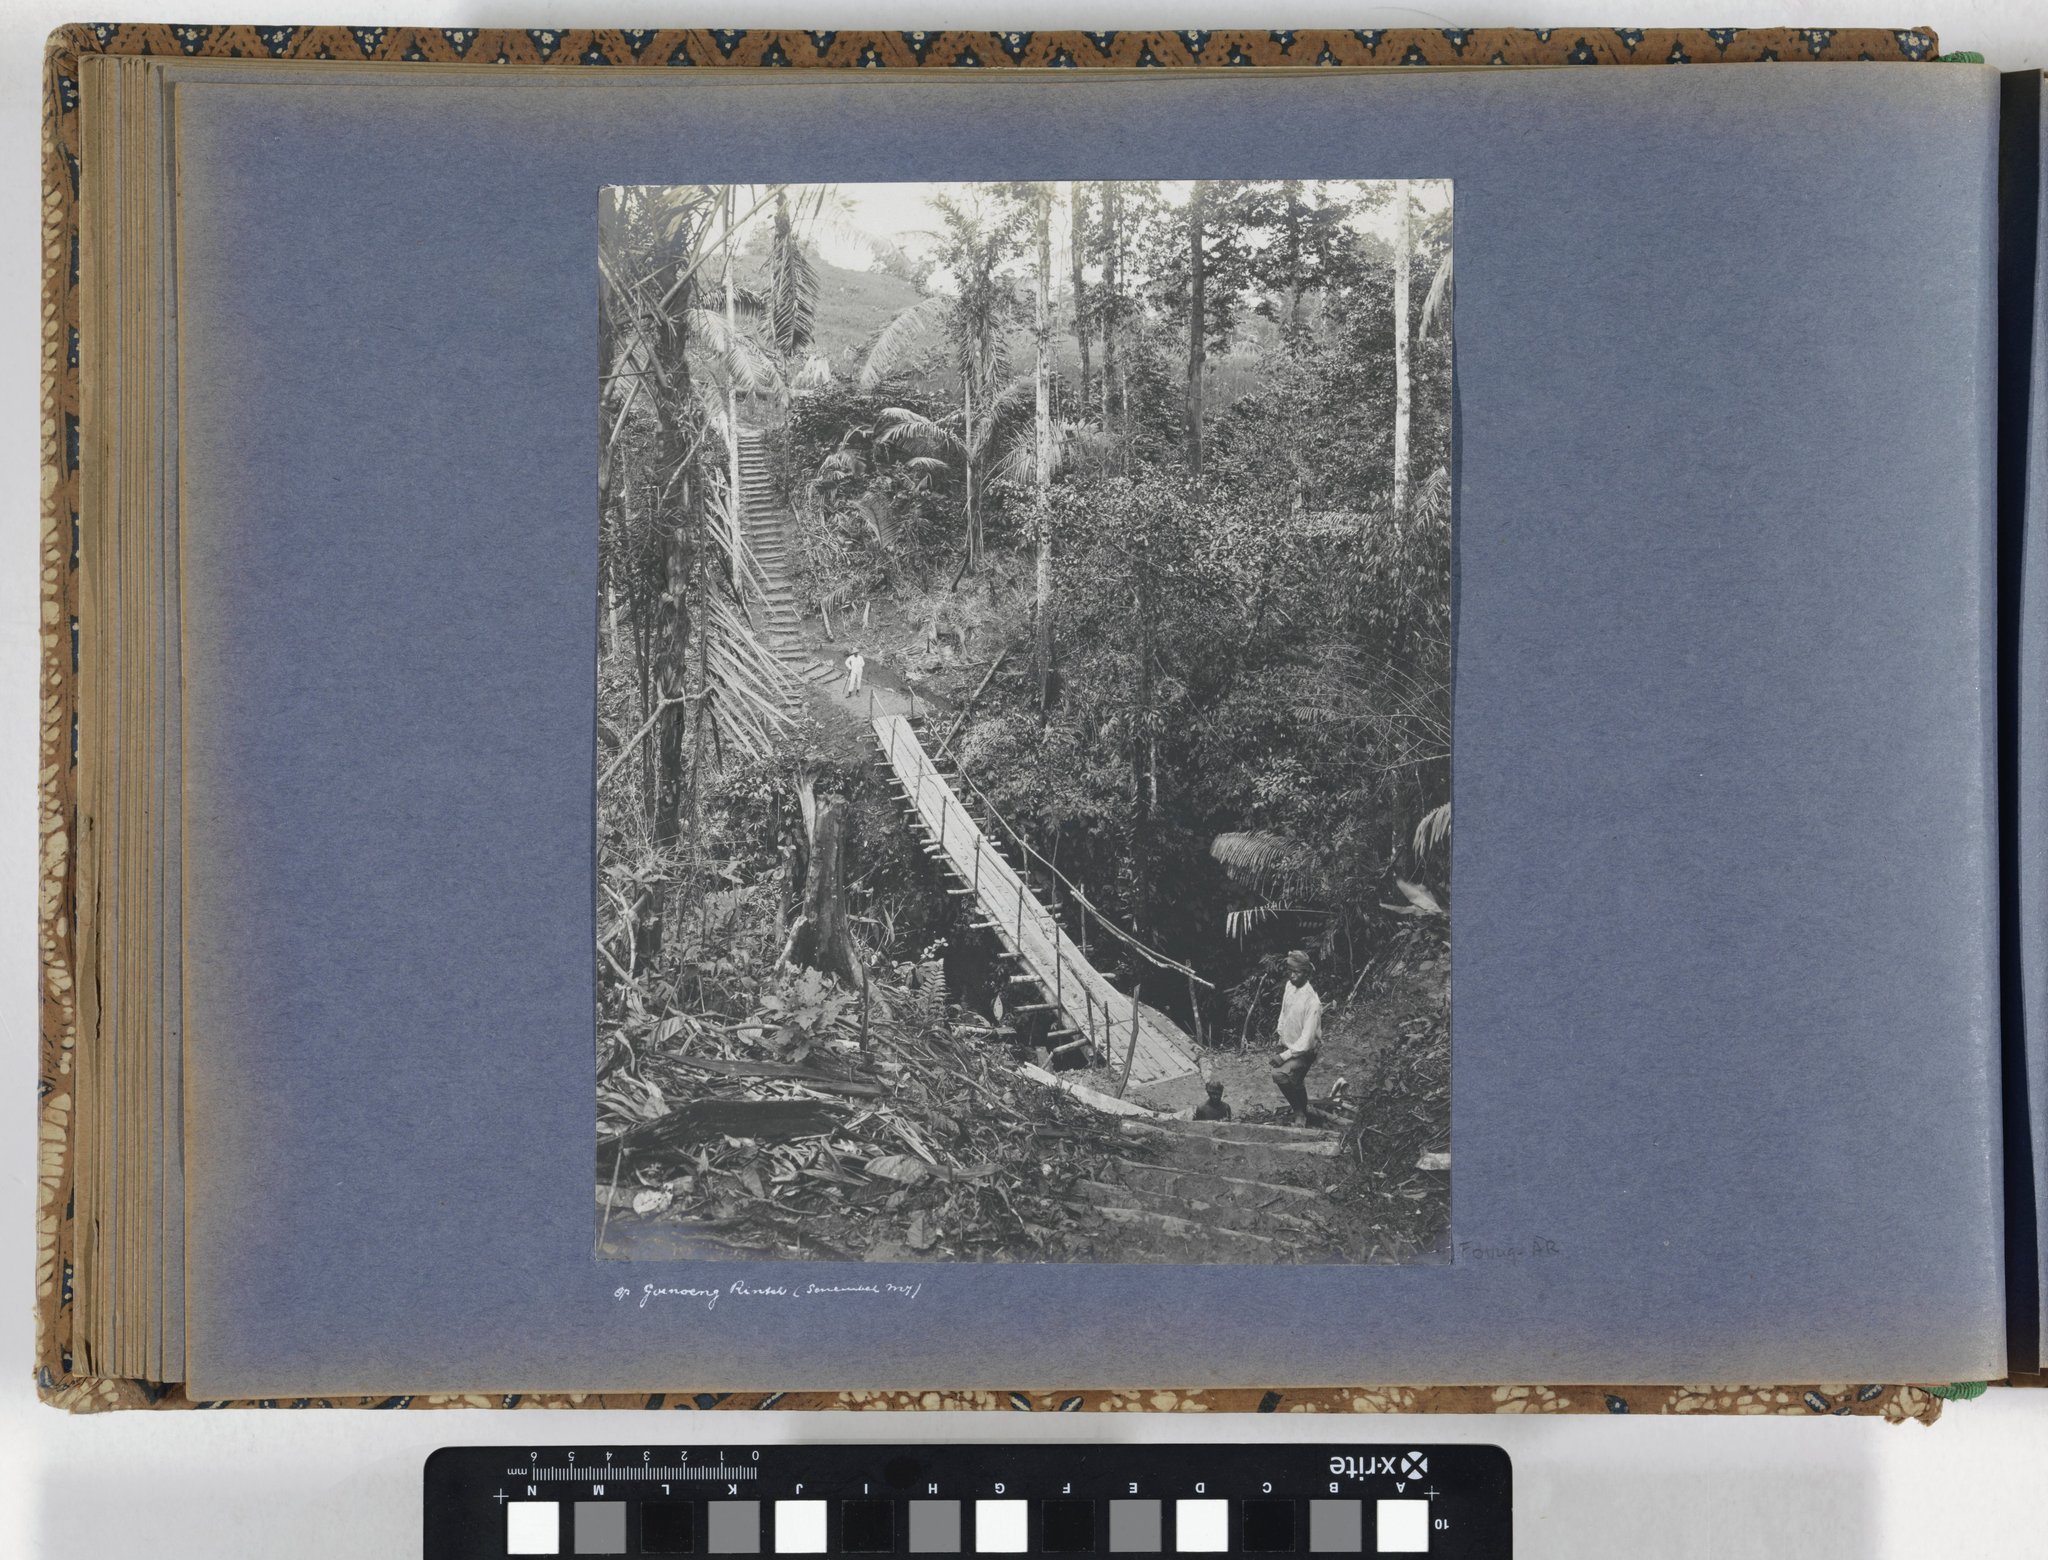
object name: photograph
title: Hangbrug in het oerwoud bij de onderneming Goenoeng Rinteh van de Senembah Maatschappij op Sumatra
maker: carl j. kleingrothe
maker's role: fotograaf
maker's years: 1864-1925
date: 1900-1915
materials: paper, photographic support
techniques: gelatin silver print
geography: sumatra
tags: plantation, suspension bridge, tobacco, sumatra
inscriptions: name: ‘Kleingrothe O.K.v.Sumatra’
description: Onderdeel van reisalbum met foto's van bedrijvigheid en bezienswaardigheden op Sumatra en Java en van de reis naar en van Nederlands-Indië.